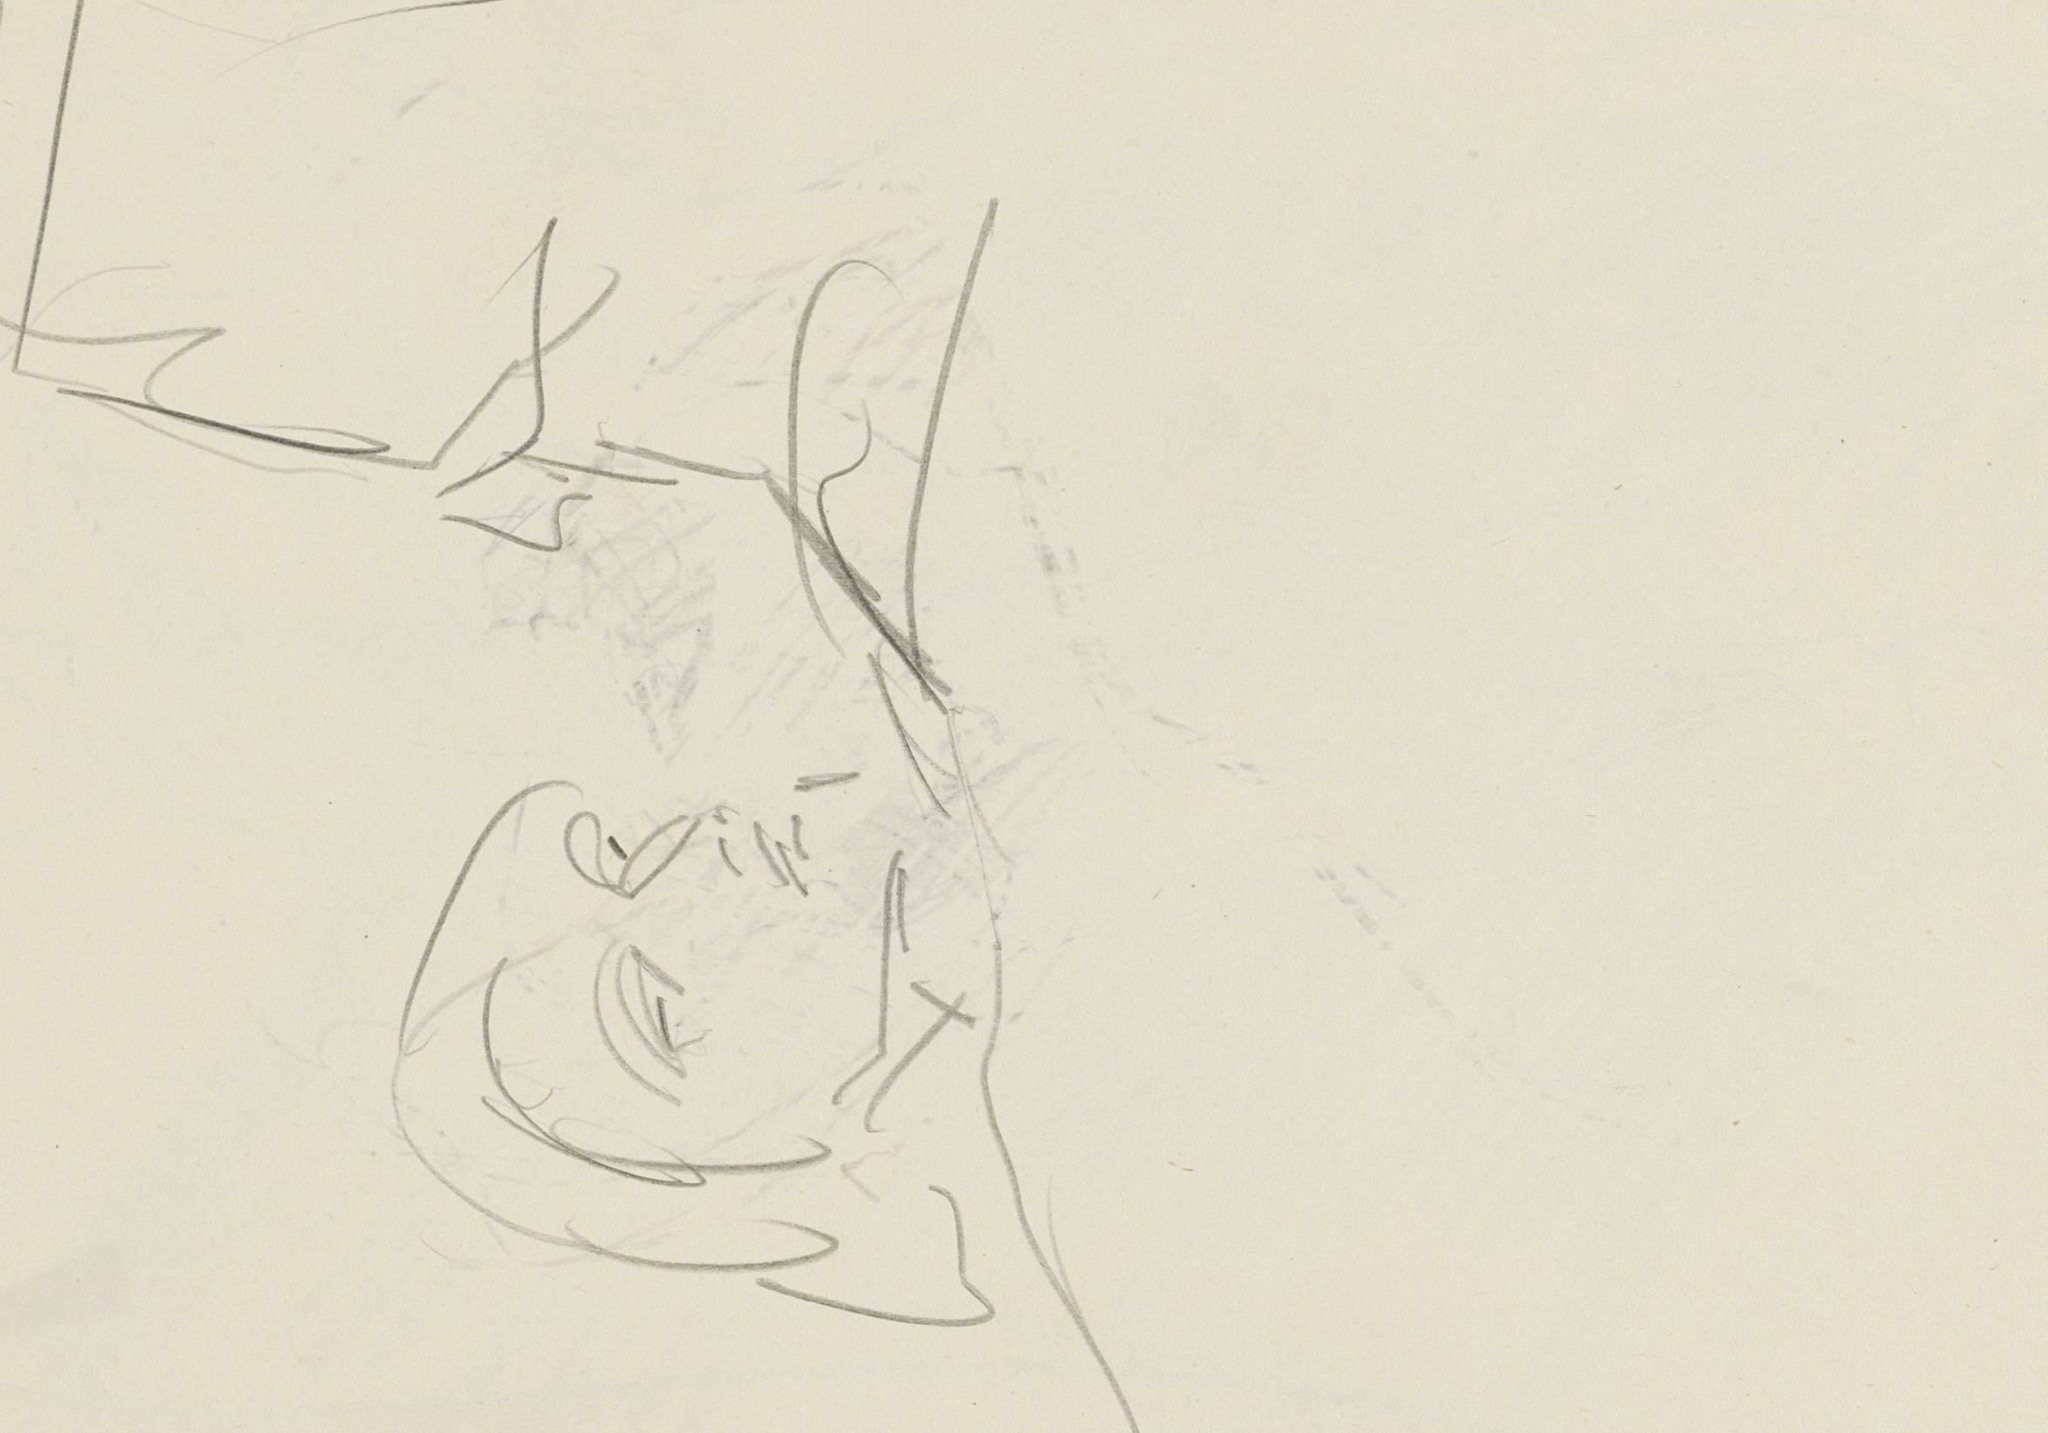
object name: sketchbook leaf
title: Vrouwenhoofd en een man met hoofddeksel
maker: isaac israels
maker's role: draughtsman, painter, print maker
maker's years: 1865-1934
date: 1915-1934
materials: paper, pencil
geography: the hague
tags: head (human), head-gear, head (human) - aa - female human figure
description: Blad 4 recto uit schetsboek XXV met 23 bladen.